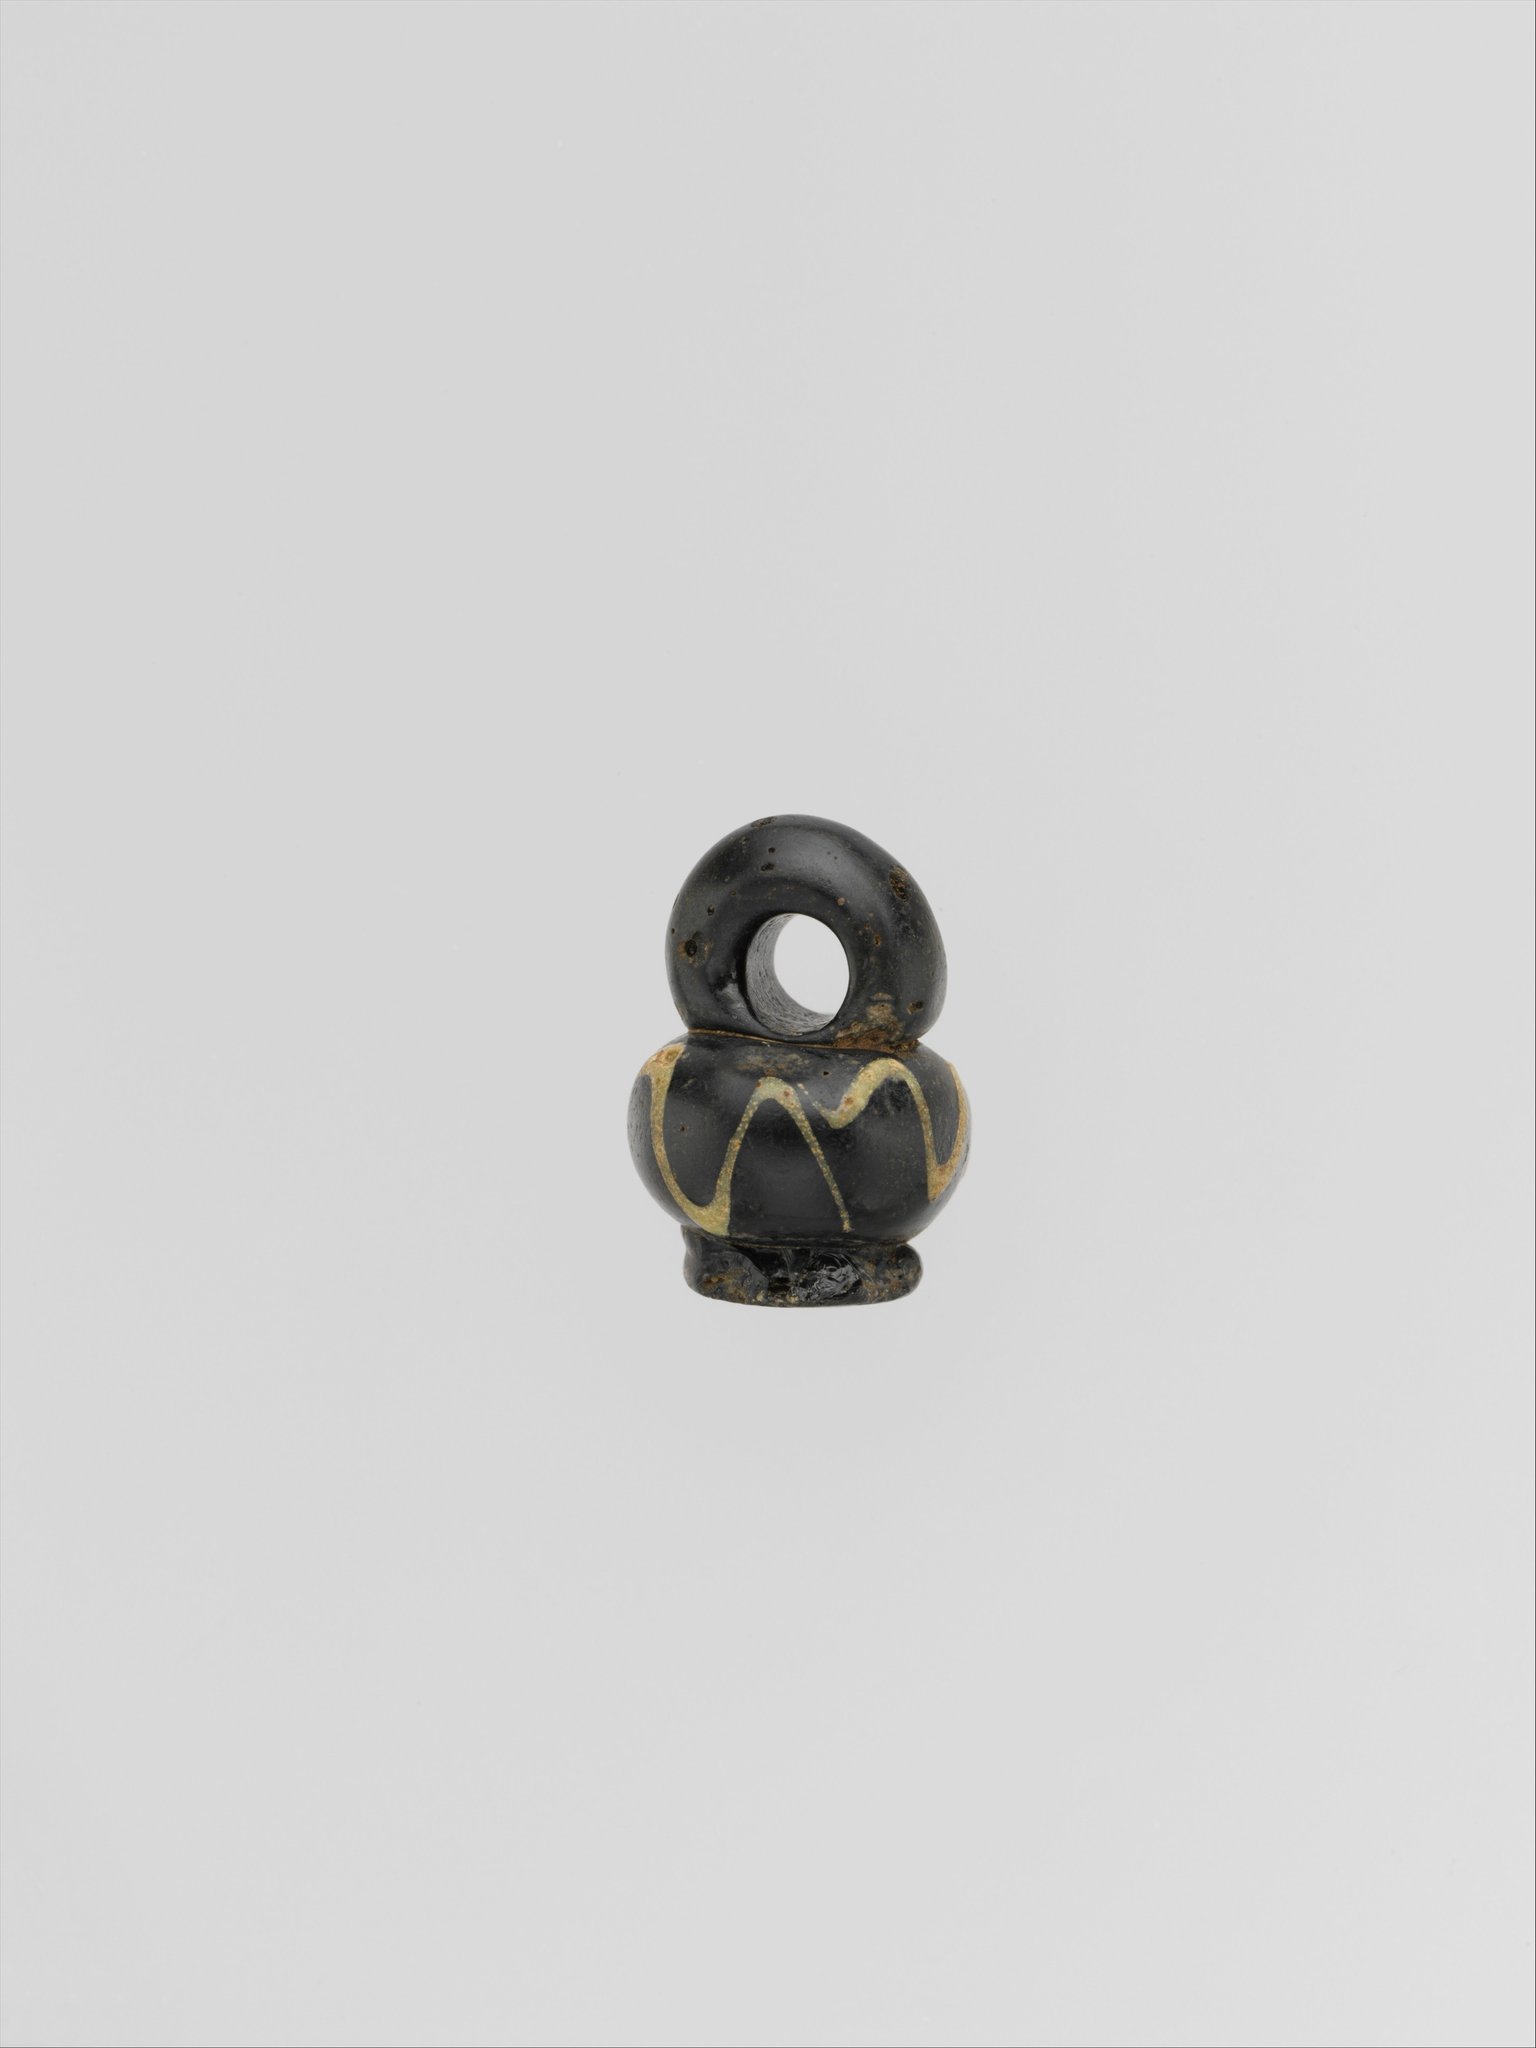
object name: pendant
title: Glass pendant shaped like a jar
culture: roman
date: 201-400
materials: glass